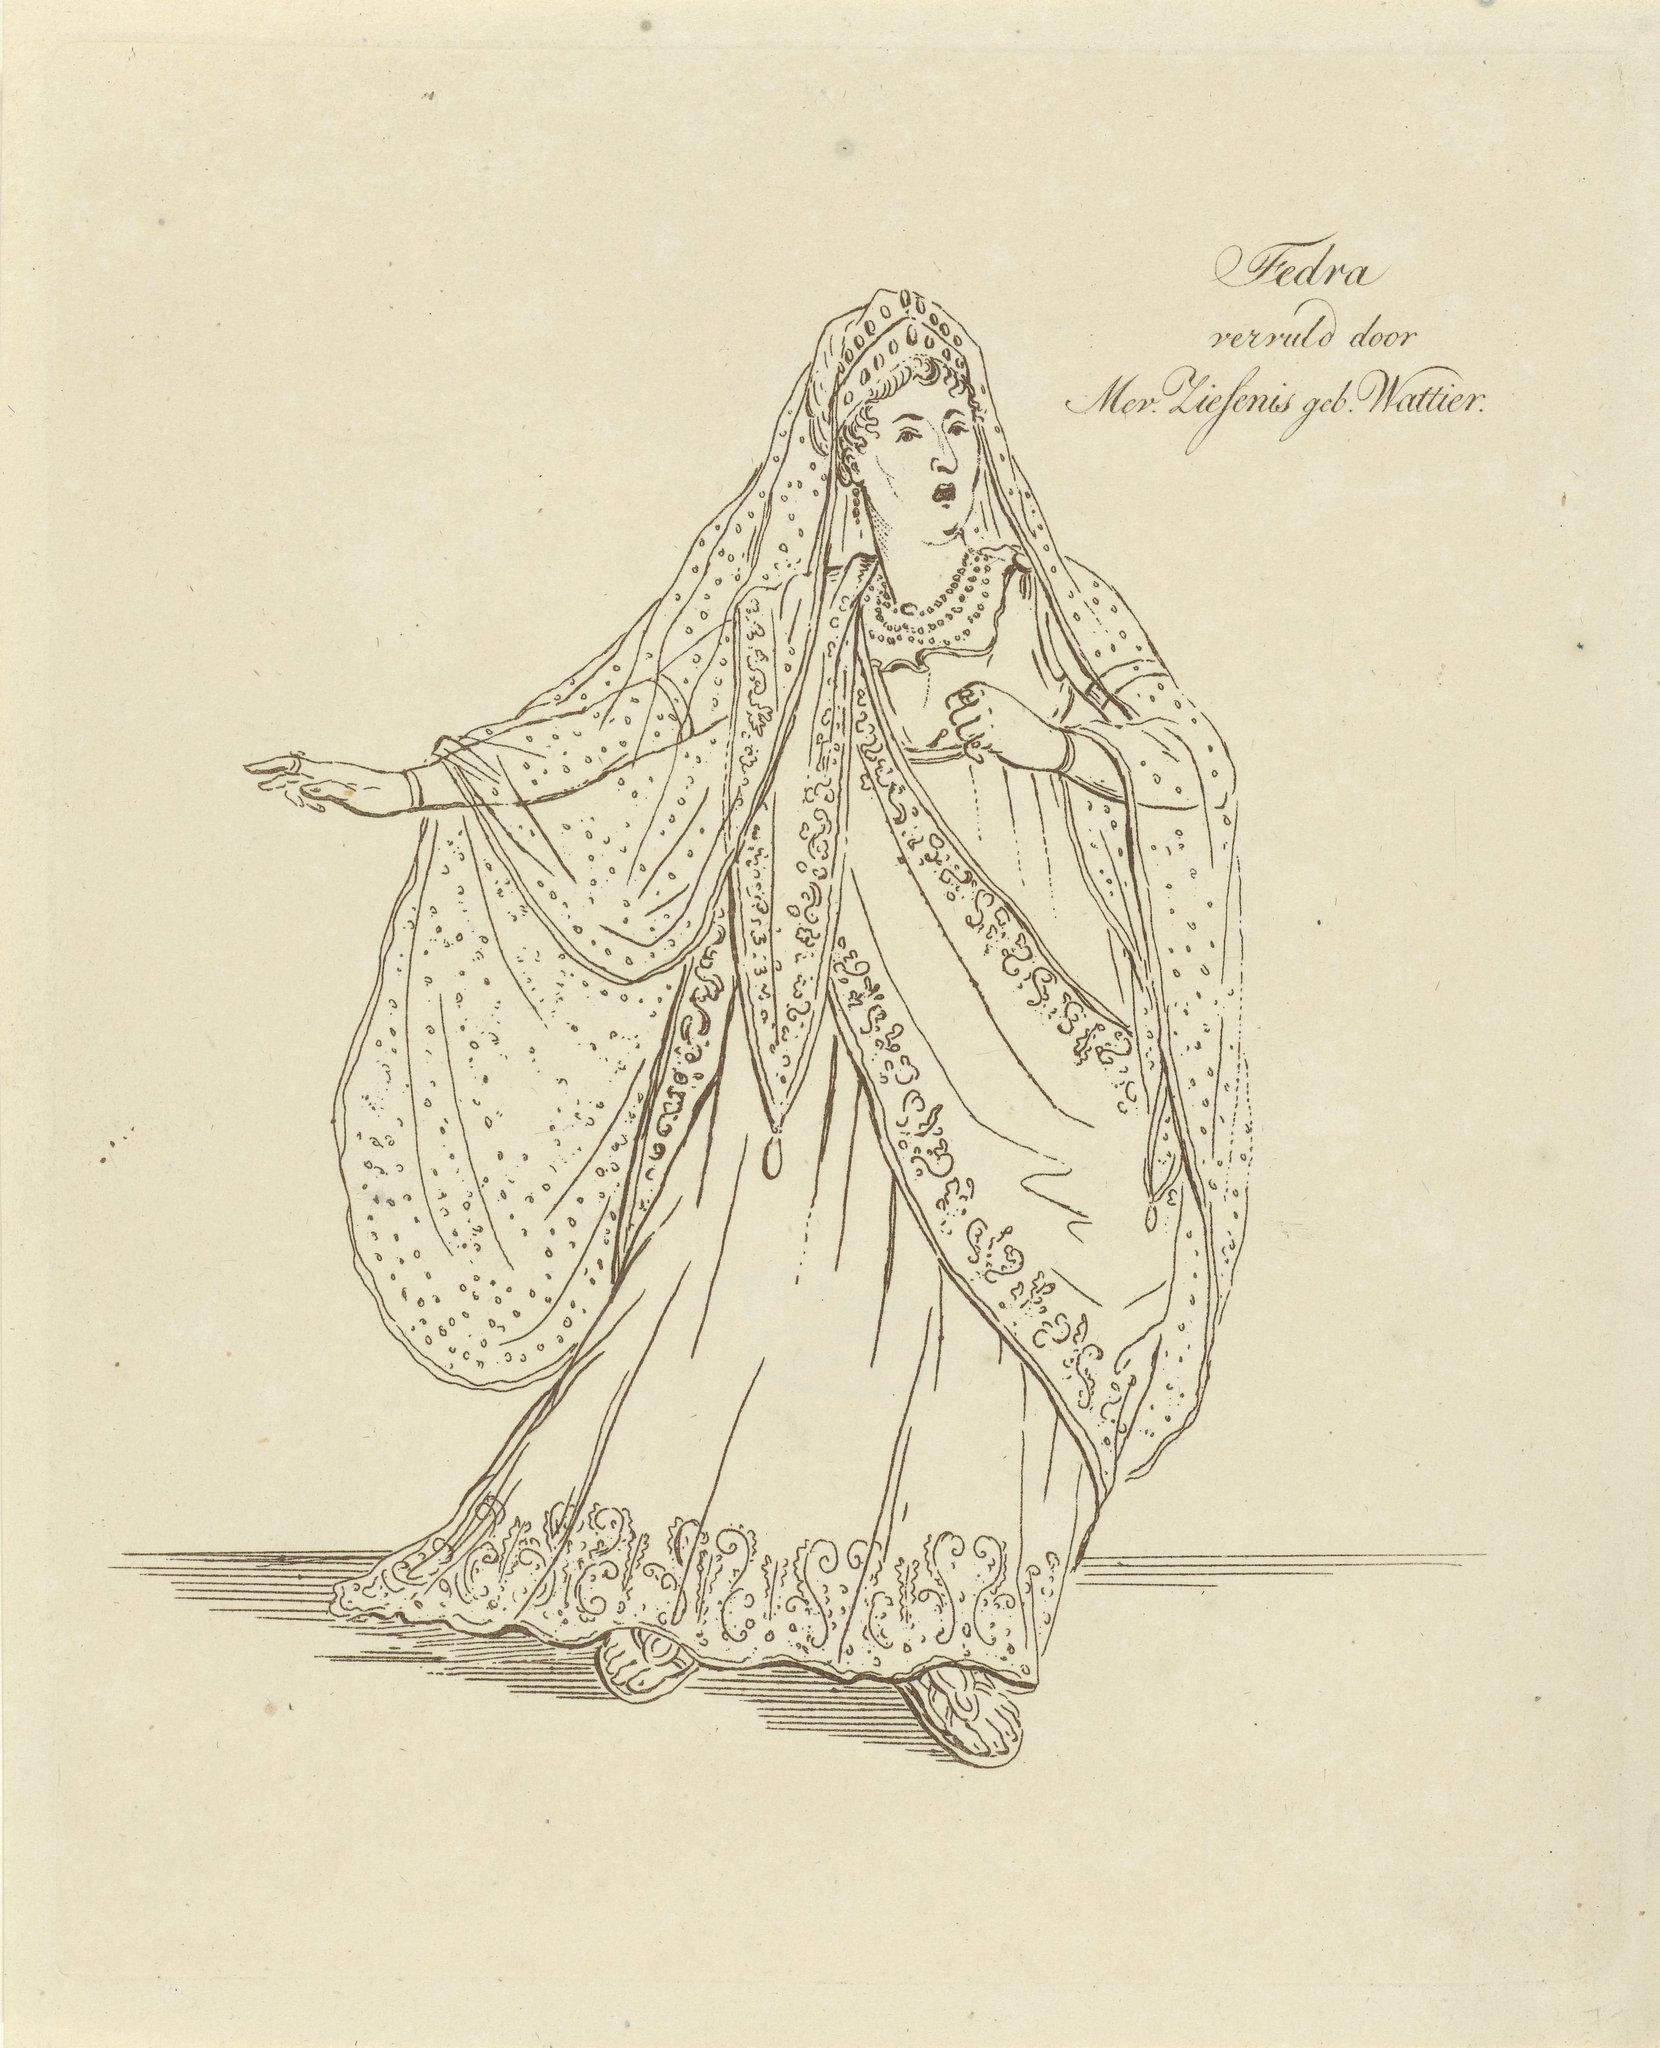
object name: print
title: Acteurs en actrices in verschillende rollen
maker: johannes jelgerhuis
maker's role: draughtsman, painter, print maker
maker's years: 1770-1836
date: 1805-1836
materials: paper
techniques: etching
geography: amsterdam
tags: actor (on the stage)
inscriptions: collector's mark: Lugt 2228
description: De actrice mevrouw Ziesenis als Fedra, gekleed in Grieks gewaad, zingend. Prent uit een serie van tien met Nederlandse acteurs en actrices in verschillende rollen.